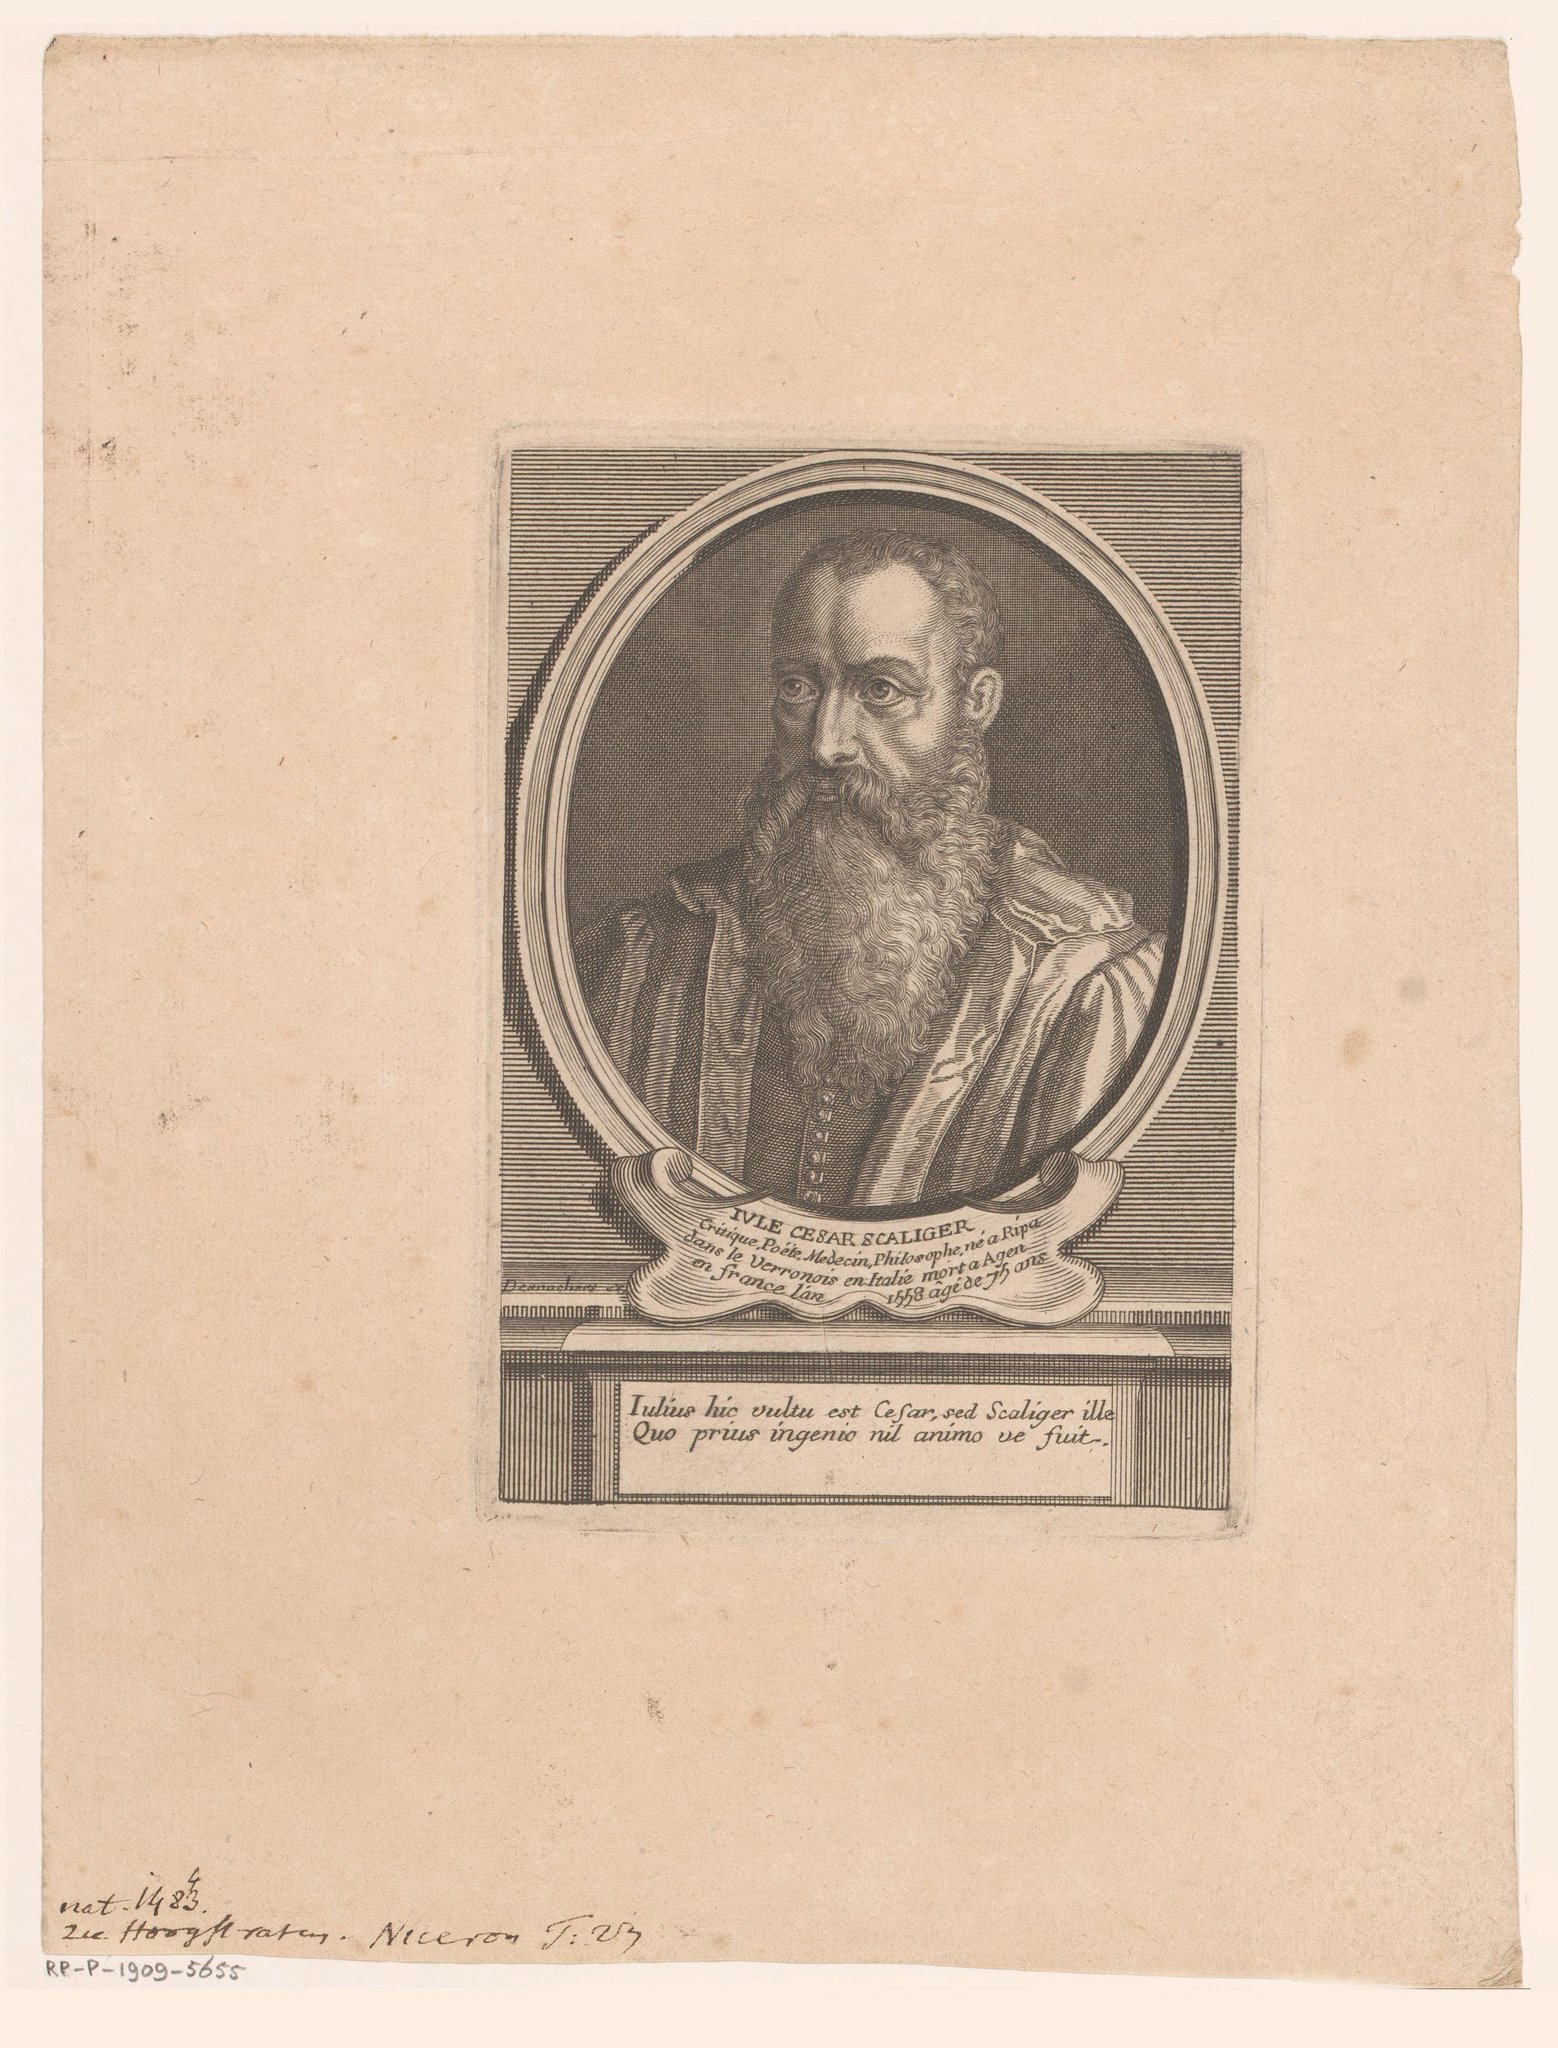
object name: print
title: Verzameling portretten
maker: étienne desrochers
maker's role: print maker, publisher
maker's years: 1668-1741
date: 1726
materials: paper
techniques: engraving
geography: paris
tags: julius caesar scaliger, scholar, philosopher, historical persons, portrait of a writer, physician, doctor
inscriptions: collector's mark: Lugt 2228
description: Behoort waarschijnlijk tot een serie portretten, grotendeels door Etienne Desrochers, getiteld: 'Recueil de portraits de personnes qui se sont distinguées tant dans les Armes que dans Belles-Lettres et les Arts, comme aussi la famille royale de France et autres cours étrangères'. De serie werd initieel uitgegeven door Desrochers en aangekondigd in 'Mercure' in mei 1726, p. 985. Echter was Desrochers reeds enkele jaren eerder begonnen met het uitgeven van de serie. Na de dood van Desrochers werd de serie voortgezet door Gilles Edme Petit. Een latere staat werd uitgegeven door Jean François Daumont in Parijs.